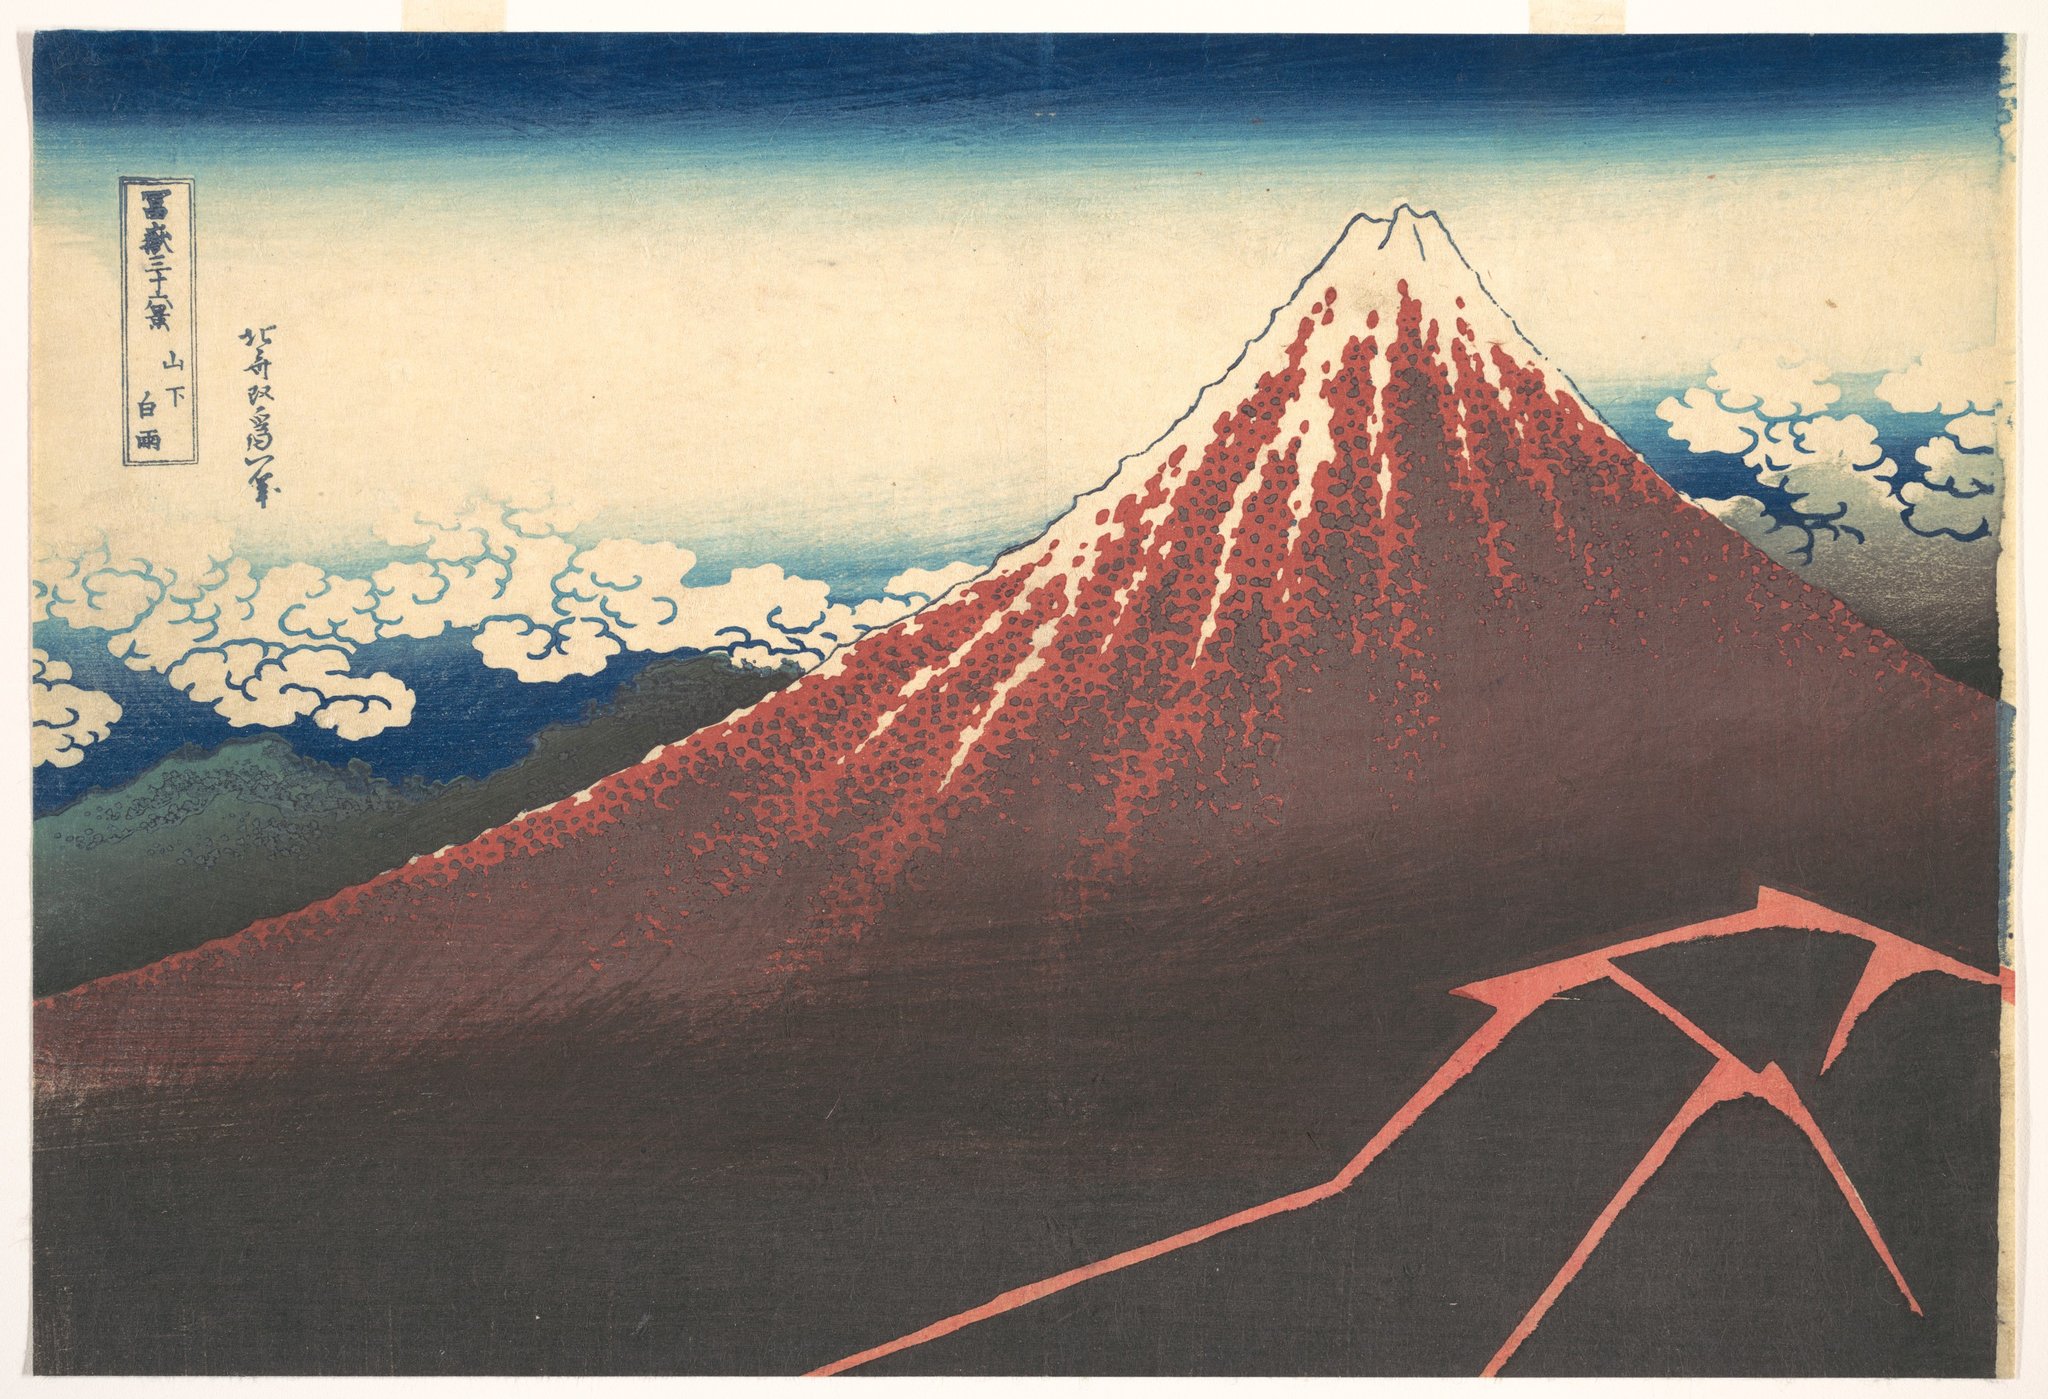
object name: print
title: Storm below Mount Fuji (Sanka no haku u), from the series Thirty-six Views of Mount Fuji (Fugaku sanjūrokkei)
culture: japanese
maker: katsushika hokusai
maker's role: artist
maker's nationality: japanese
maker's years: 1760-1849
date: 1830-1832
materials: ink, paper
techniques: woodblock print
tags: volcanoes